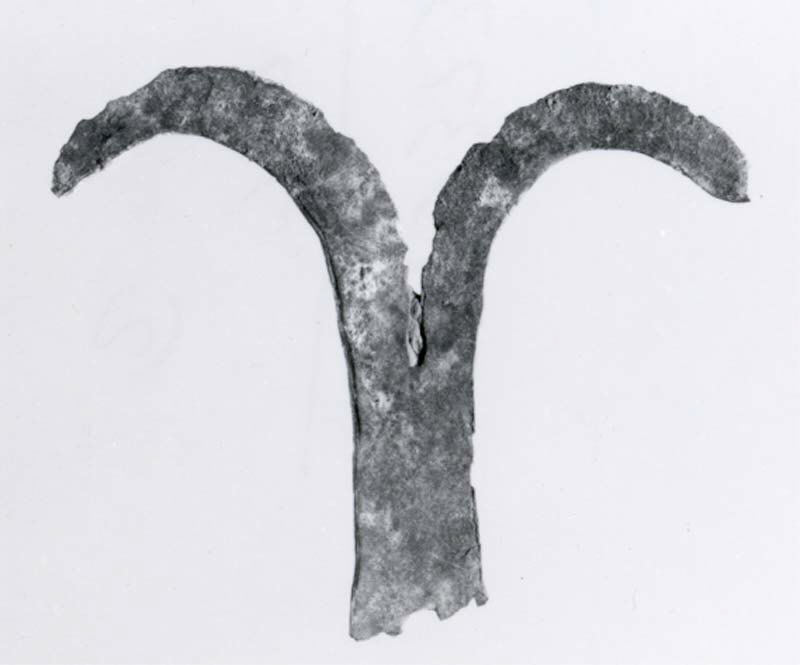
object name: foundation peg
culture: sumerian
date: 2600-2350 BCE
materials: bronze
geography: mesopotamia